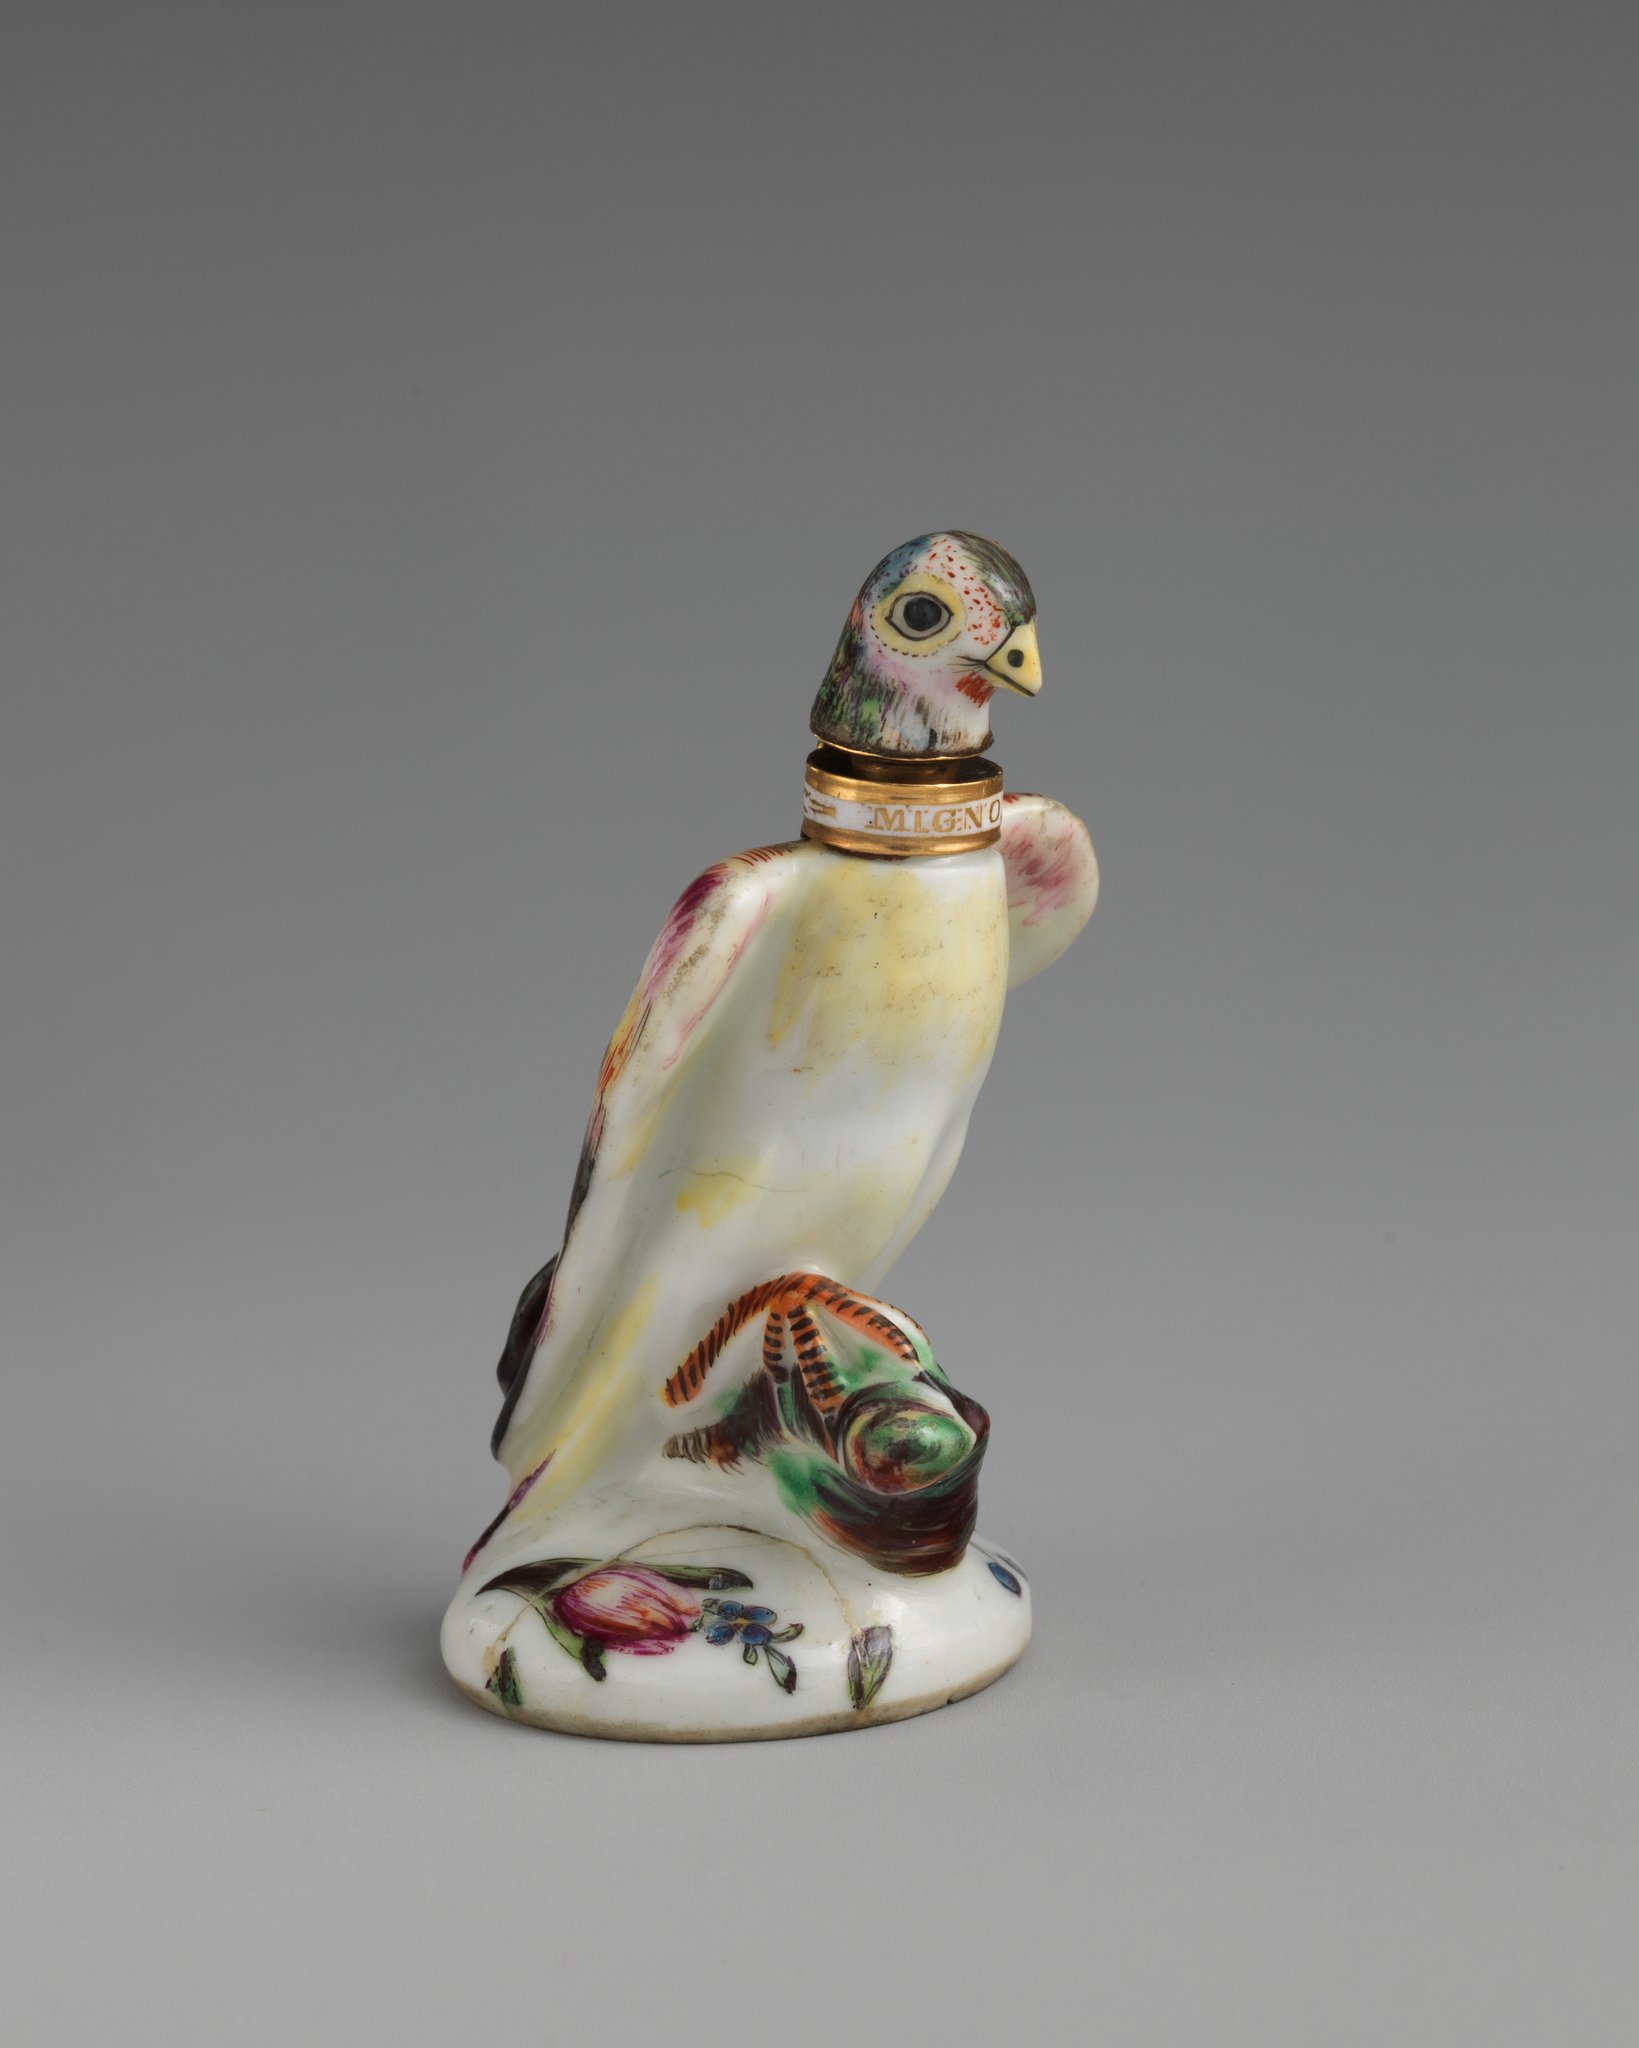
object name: toy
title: Bird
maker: saint james's factory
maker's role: maker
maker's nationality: british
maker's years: 1749-1759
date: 1750-1755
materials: soft paste porcelain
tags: birds